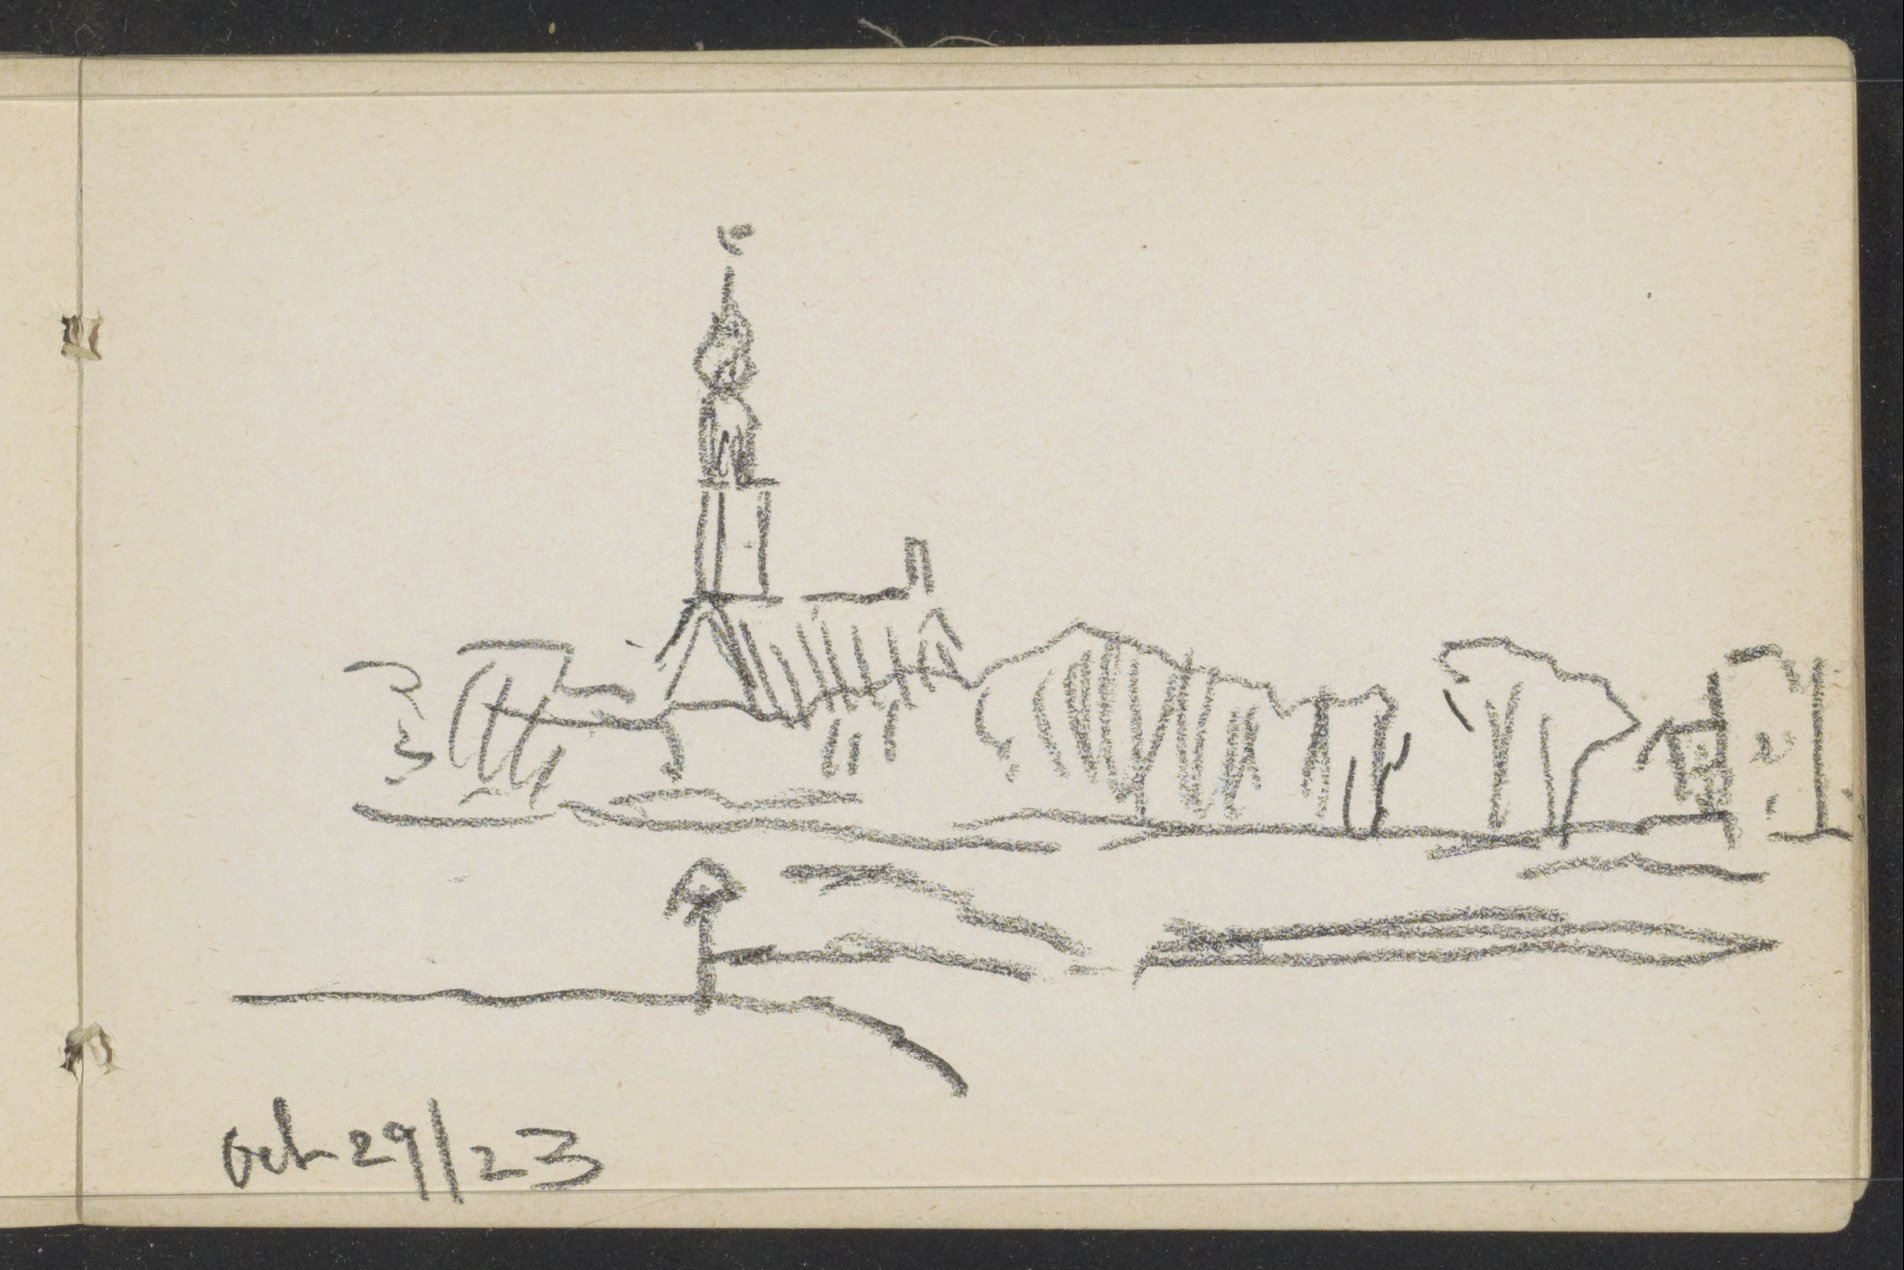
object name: sketchbook leaf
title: Gezicht op Veere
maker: alexander shilling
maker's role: draughtsman, print maker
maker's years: 1859-1937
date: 1910-1923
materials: chalk, paper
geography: veere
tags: prospect of village, silhouette of village, tower (of house or building)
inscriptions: date: ‘Oct 29/23’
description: Dorpsgezicht met de toren van het stadhuis. Blad 21 recto uit een schetsboek met 26 bladen.